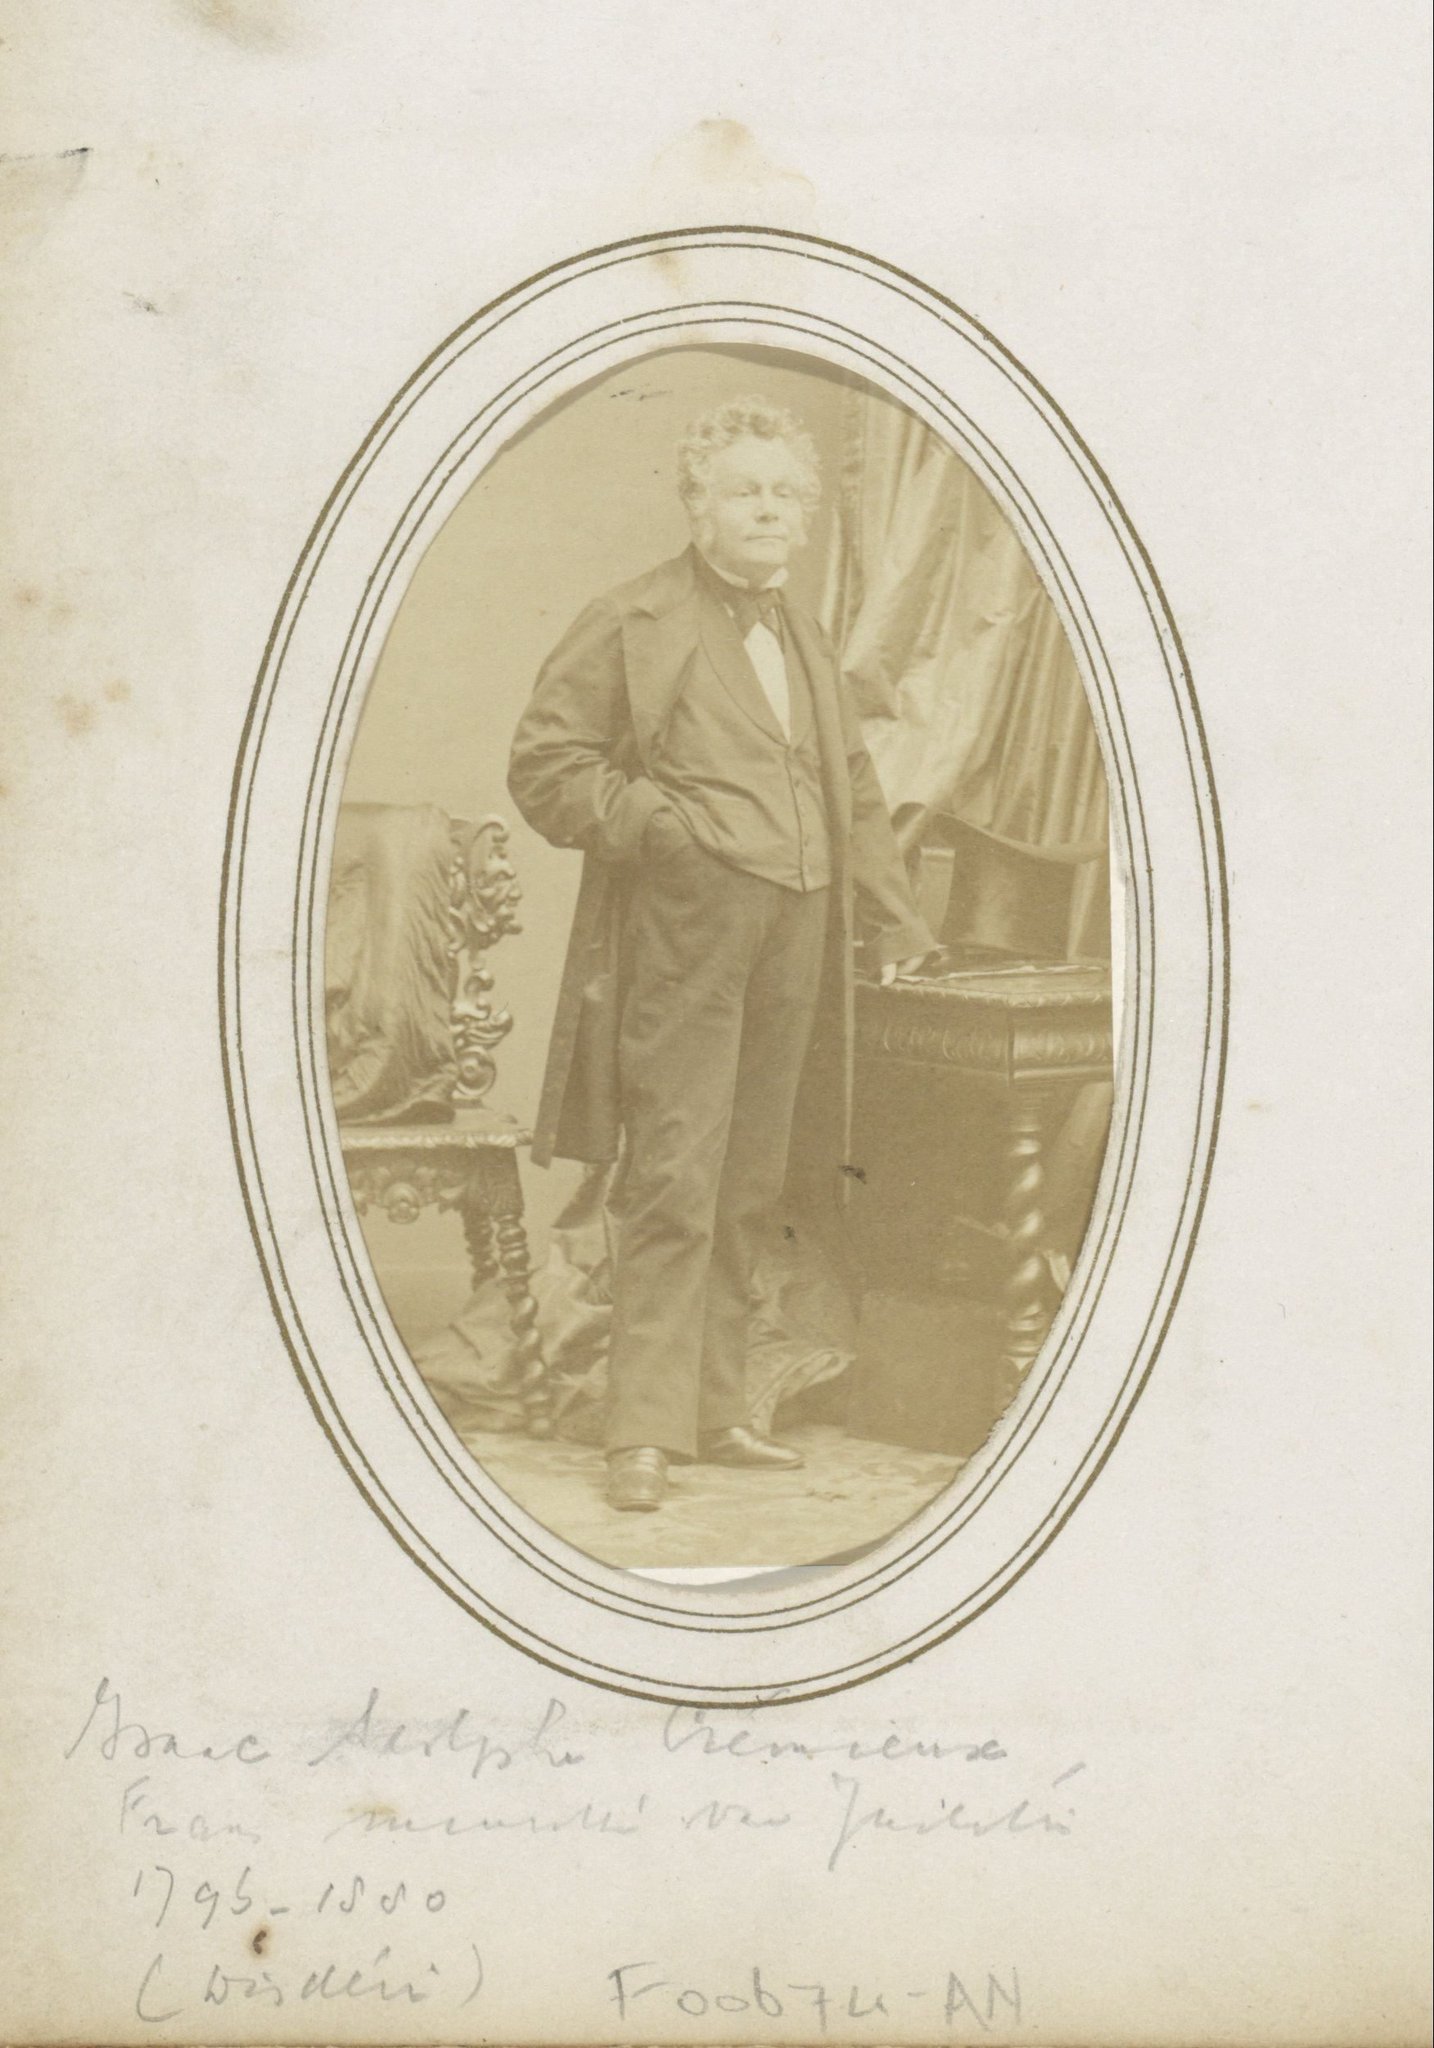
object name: photograph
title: Portret van Isaac Adolphe Crémieux, Frans politicus en minister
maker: andré-adolphe-eugène disdéri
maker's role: fotograaf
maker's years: 1819-1889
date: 1855-1870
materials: cardboard, paper, photographic support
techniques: albumen print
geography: paris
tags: politician, minister ~ government, sideburns, studio requisites ~ photographer, trousers, breeches, historical persons, clothing for the upper part of the body, shoes, sandals, hairdress, coat, cape, paris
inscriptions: address: ‘Paris, 8, Boulevard des Italiens’, inscription: ‘Crémieux’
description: Onderdeel van Fotoalbum met 123 cartes-de-visite van leden van Europese vorstenhuizen, politici en bekende personen.